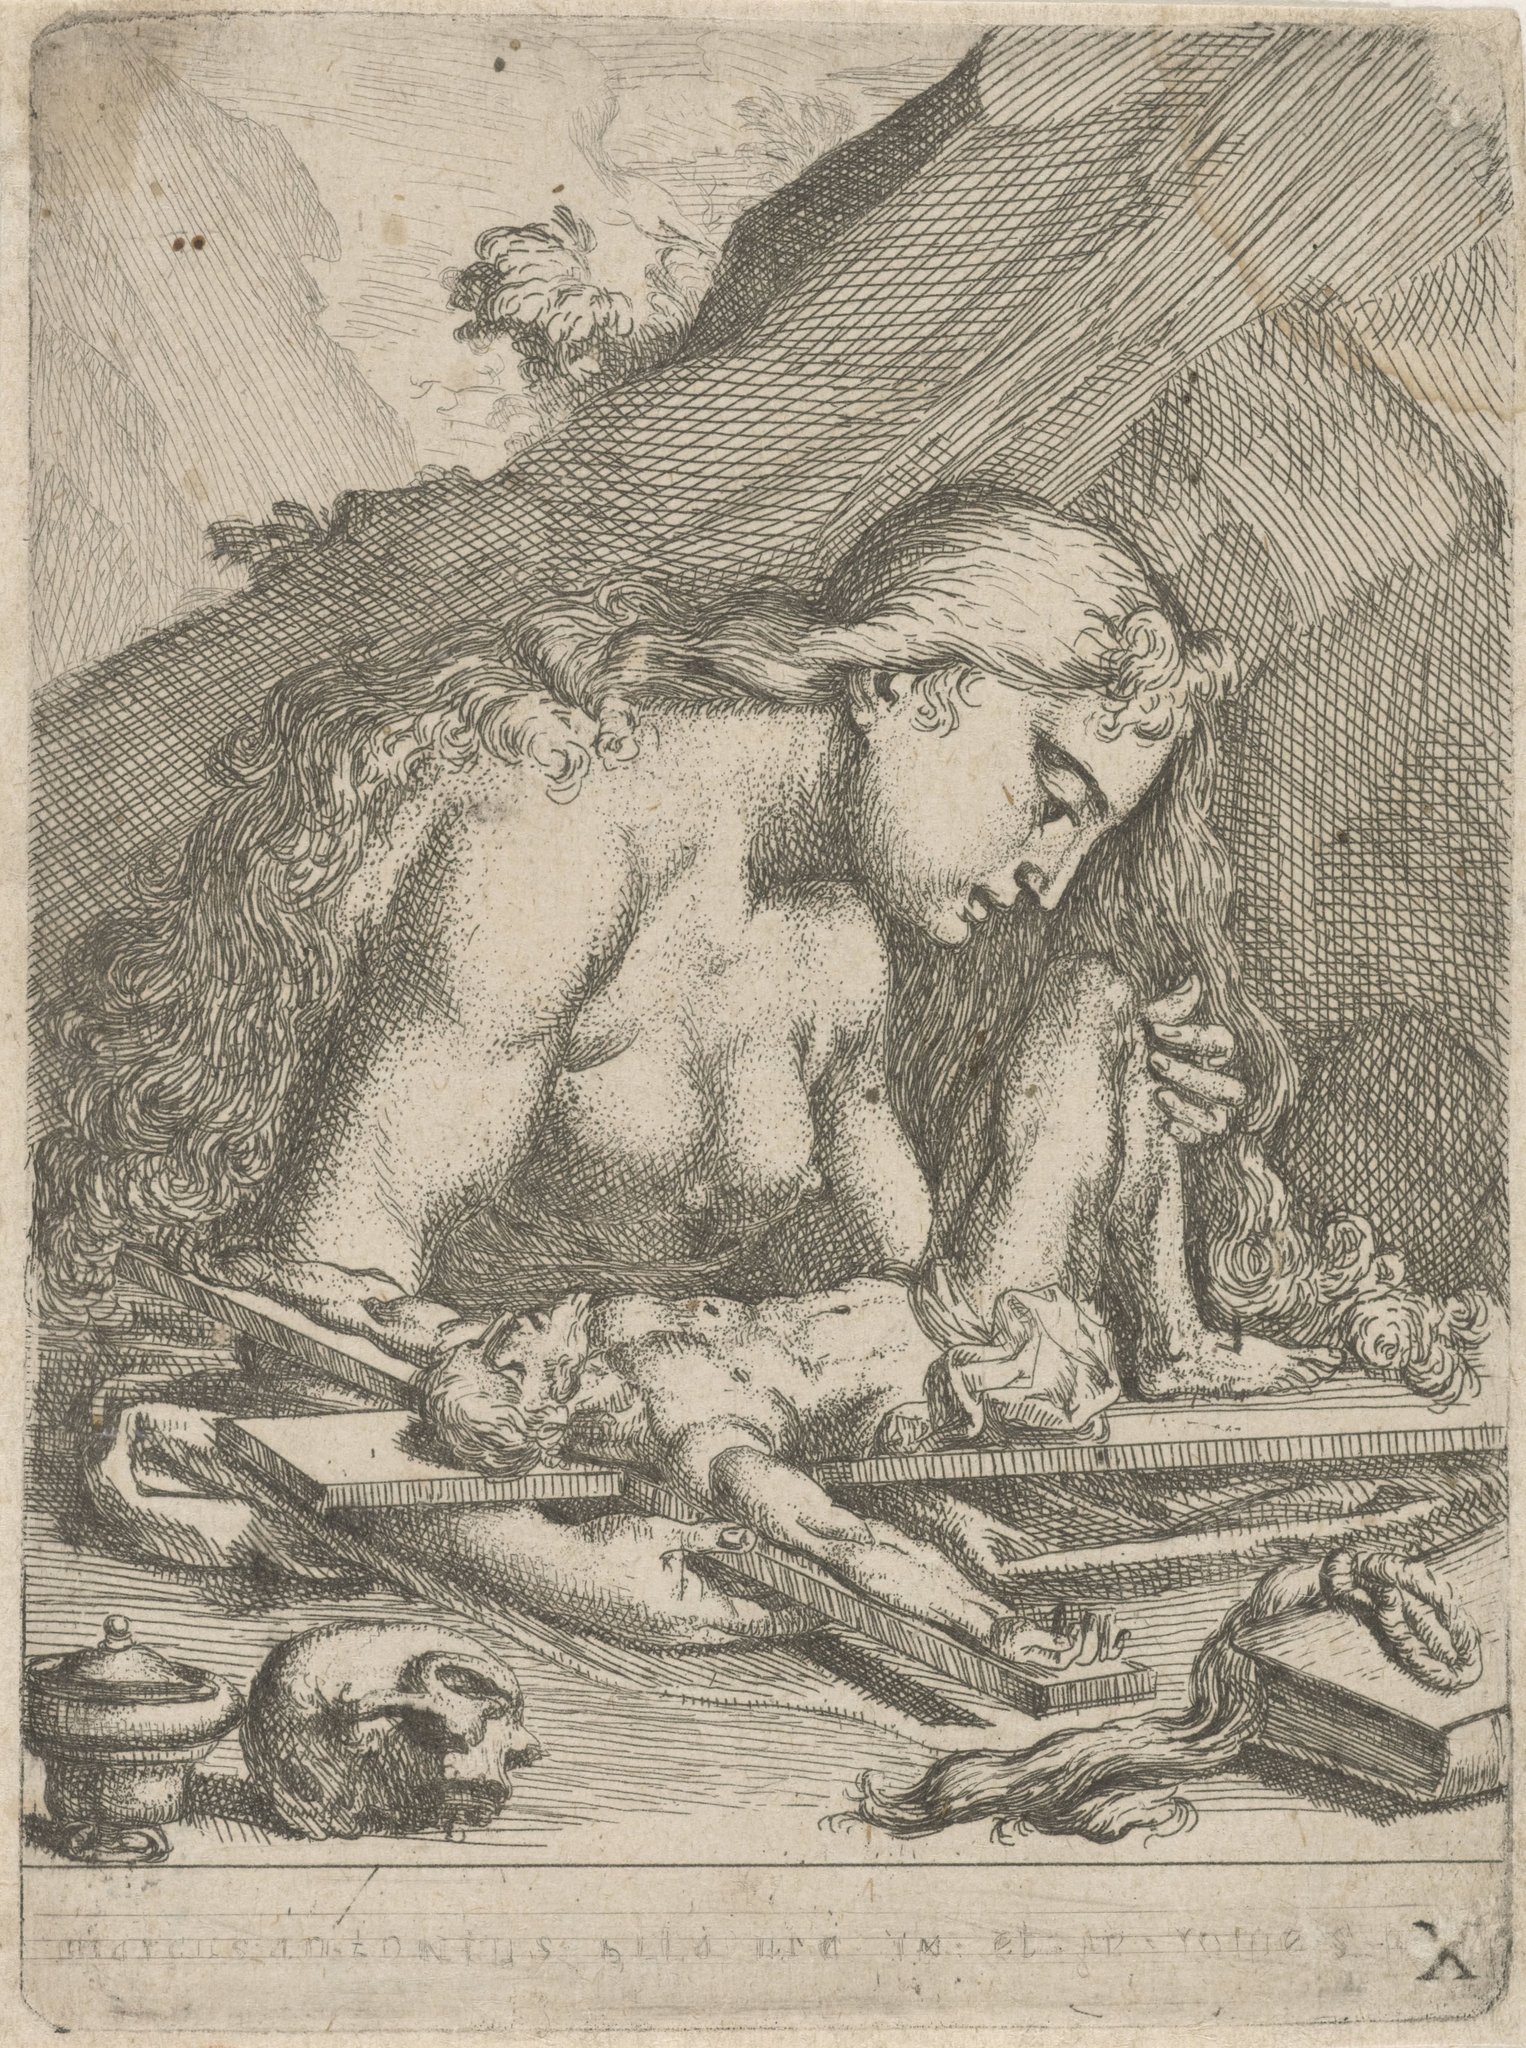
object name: print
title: H. Maria Magdalena als boetvaardige zondares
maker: françois joseph lonsing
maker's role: print maker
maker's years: 1739-1799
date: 1749-1799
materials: paper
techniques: etching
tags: the penitent harlot mary magdalene; possible attributes: book (or scroll), crown, crown of thorns, crucifix, jar of ointment, mirror, musical instrument, palm-branch, rosary, scourge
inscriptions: collector's mark: Lugt 2228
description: De heilige Maria Magdalena, berouwvol met een crucifix in haar armen.